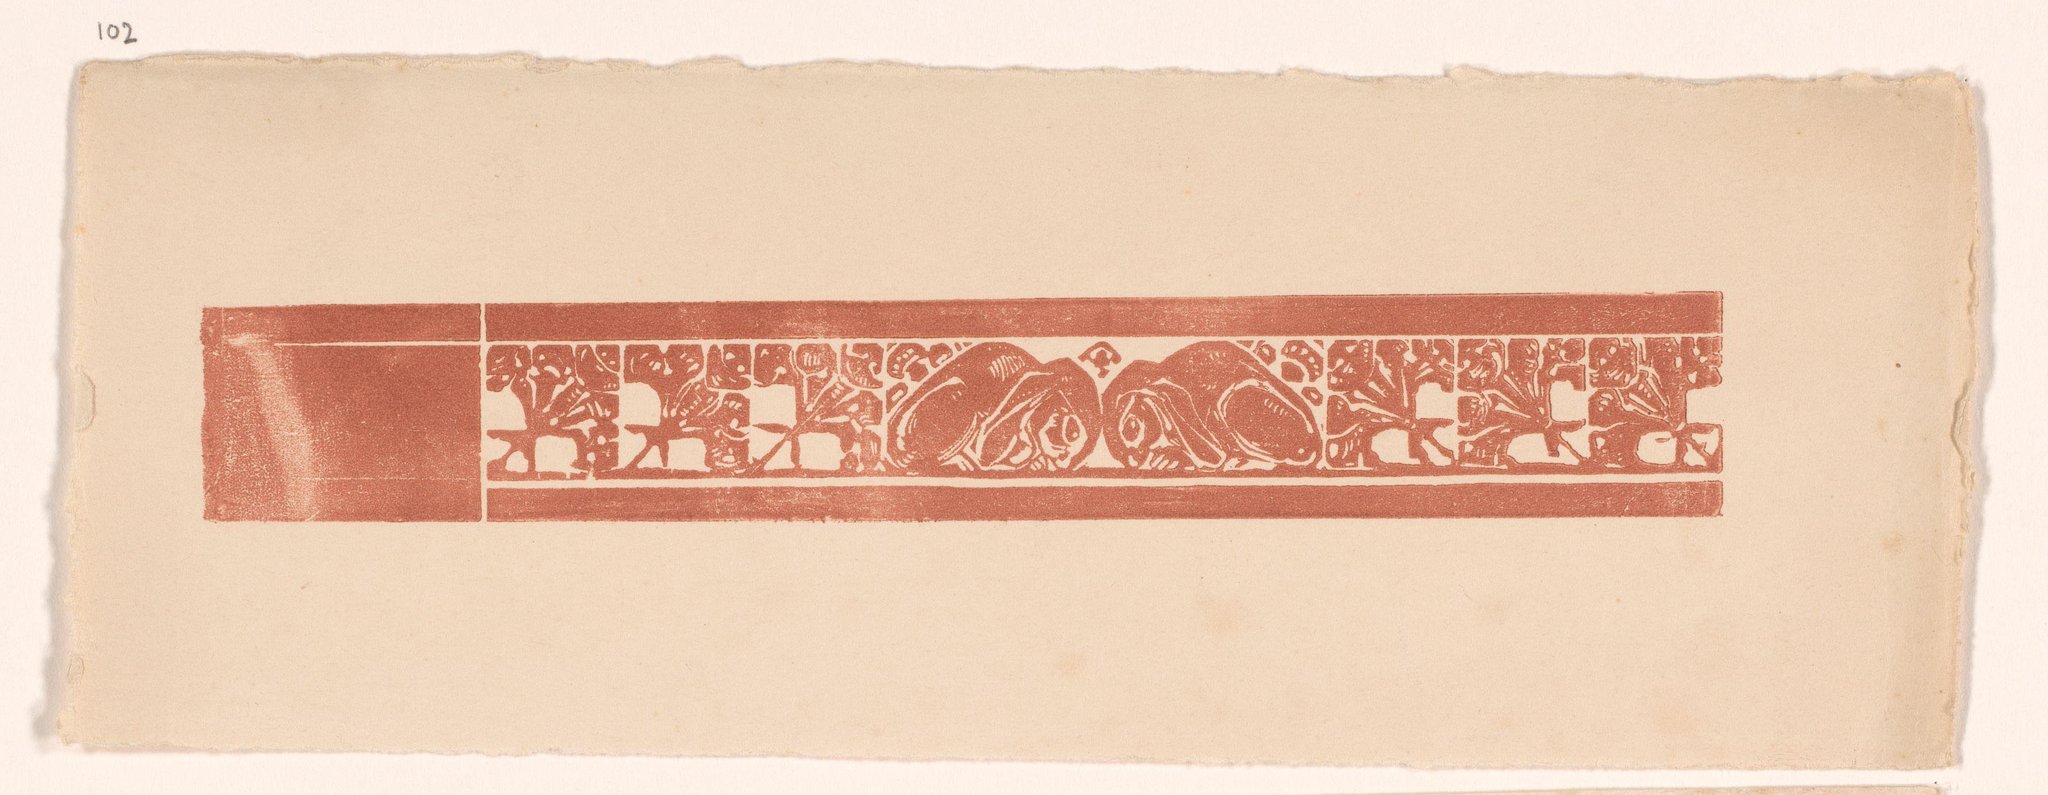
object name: boekillustratie ontwerp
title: Ornamentele rand met konijnen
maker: bernard willem wierink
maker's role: draughtsman, print maker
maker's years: 1856-1939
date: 1910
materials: paper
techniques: relief print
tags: fable of reynard the fox, rodents: rabbit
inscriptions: collector's mark: Lugt 2228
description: Ontwerp voor: Streuvels, Stijn (Frank Lateur). Reinaert de Vos naar verschillende uitgaven van het middeleeuwsche epos. Amsterdam: L.J. Veen, 1910. Deze prent is vermoedelijk een plaatsnede, ook al wordt in de literatuur veelal gesproken over een houtsnede. Voor zover Wierink zijn prenten in hoogdruk zelf nader heeft omschreven, heeft hij altijd de term 'plaatsnede' gebruikt.